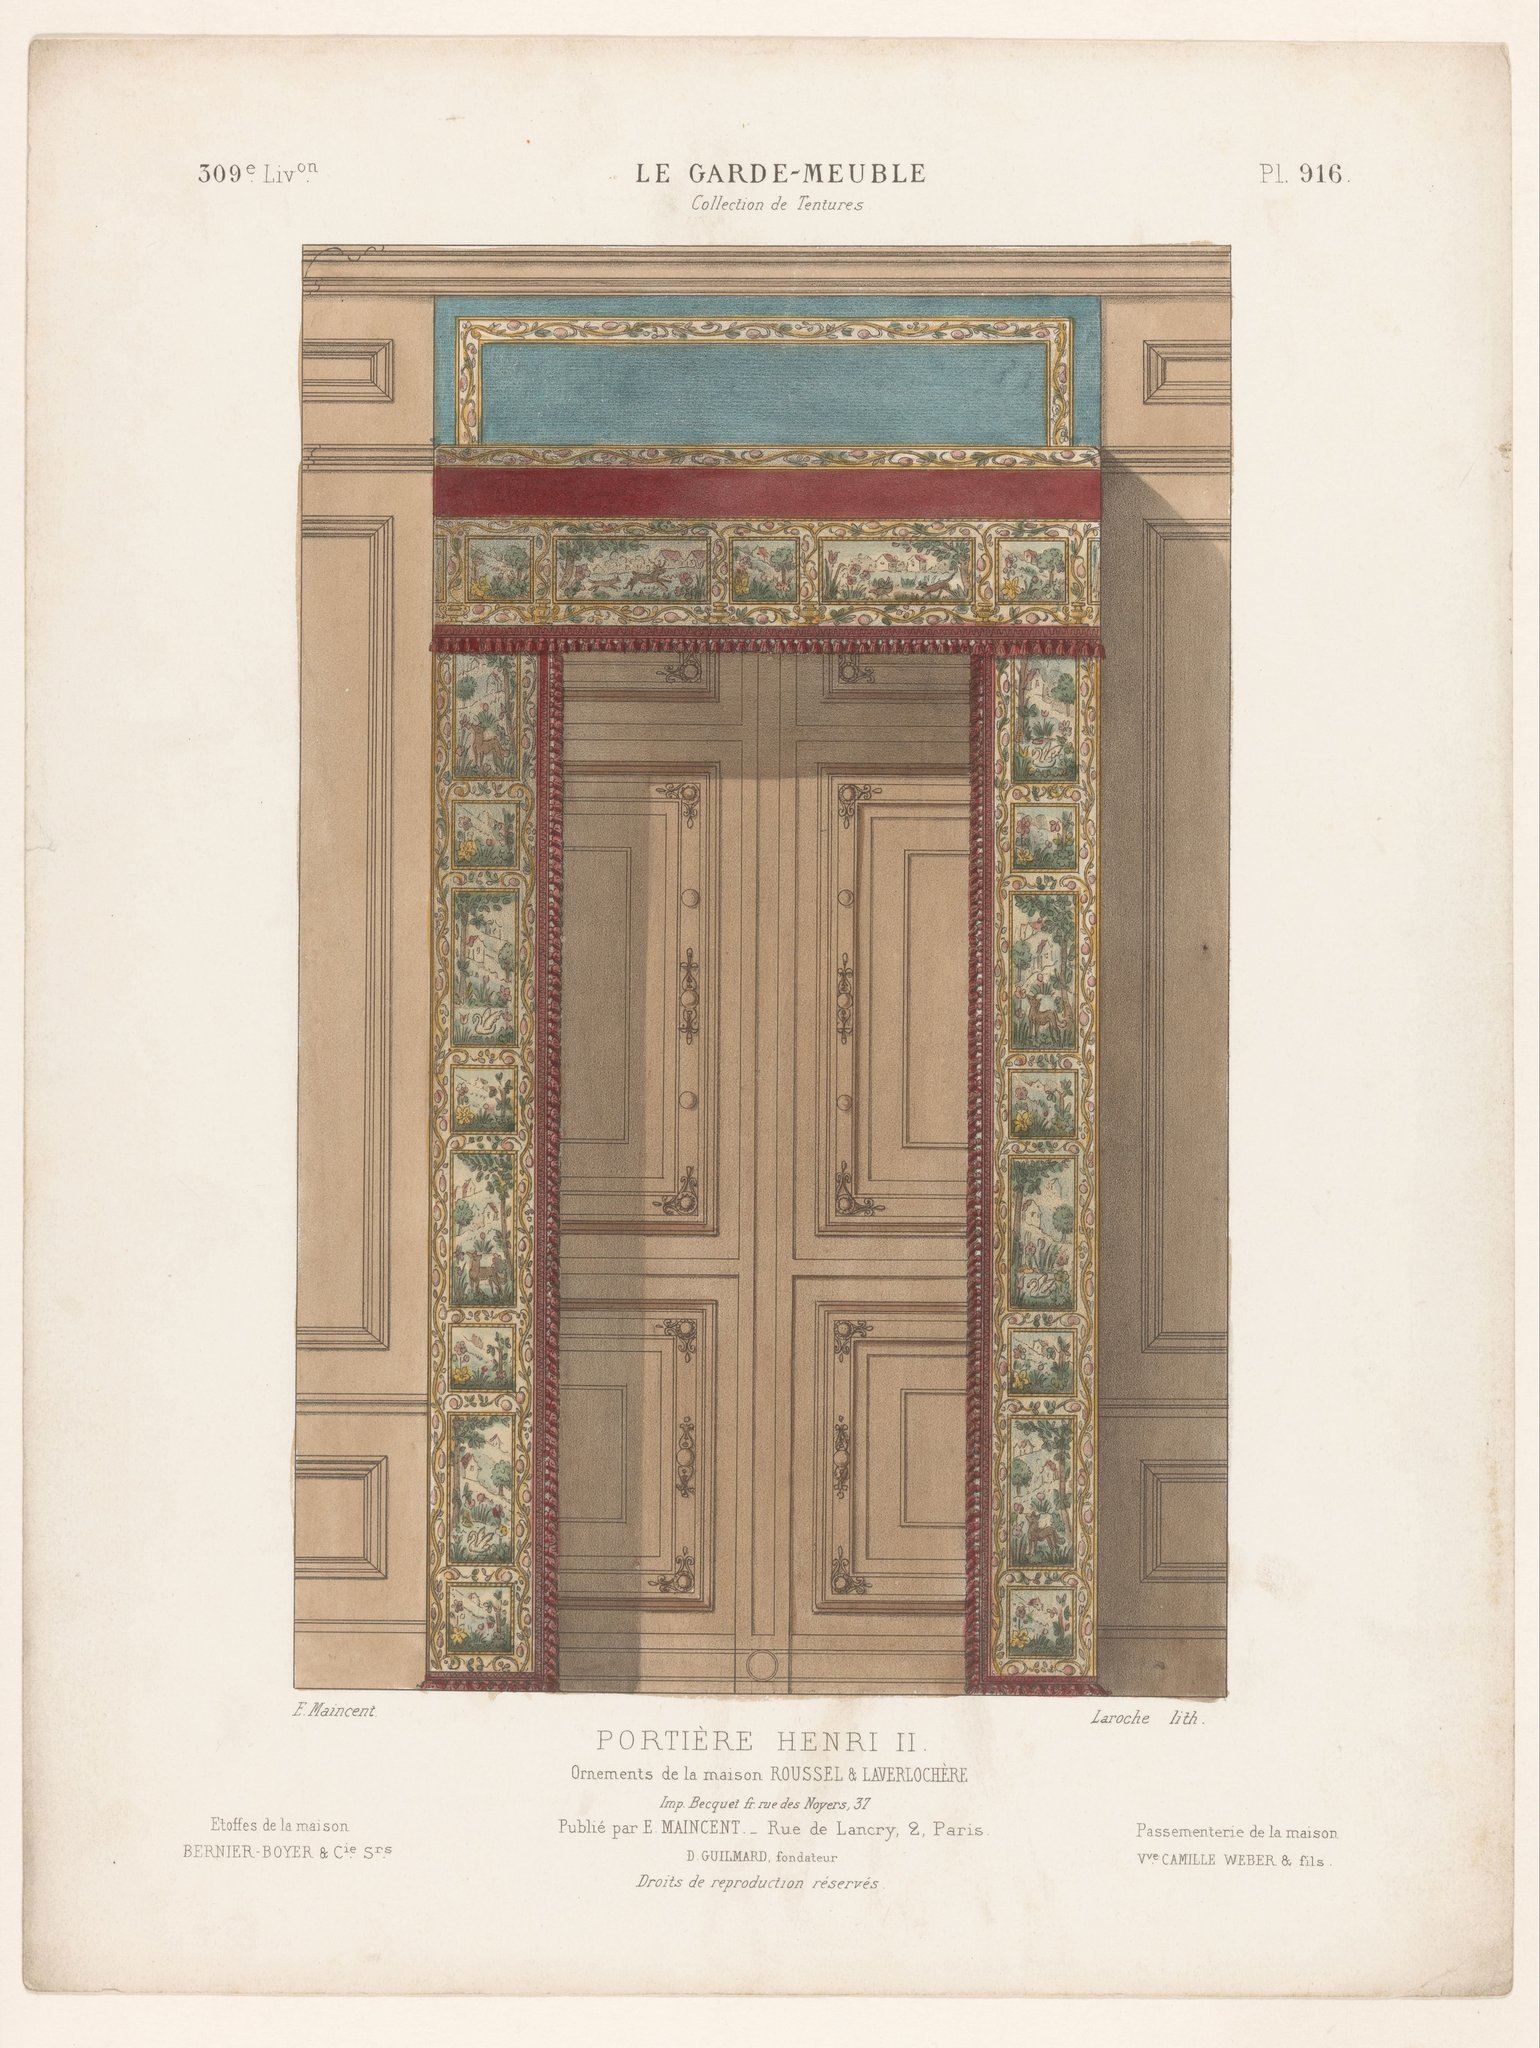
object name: print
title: Portière Henri II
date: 1885-1895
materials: paper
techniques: hand coloring, lithograph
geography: paris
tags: window, hangings and drapery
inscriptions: : ‘Droits de reproduction réservés.’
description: Deur met decoratieve omlijsting van textiel in de Hendrik II-stijl. Prent uit 309e Livraison.